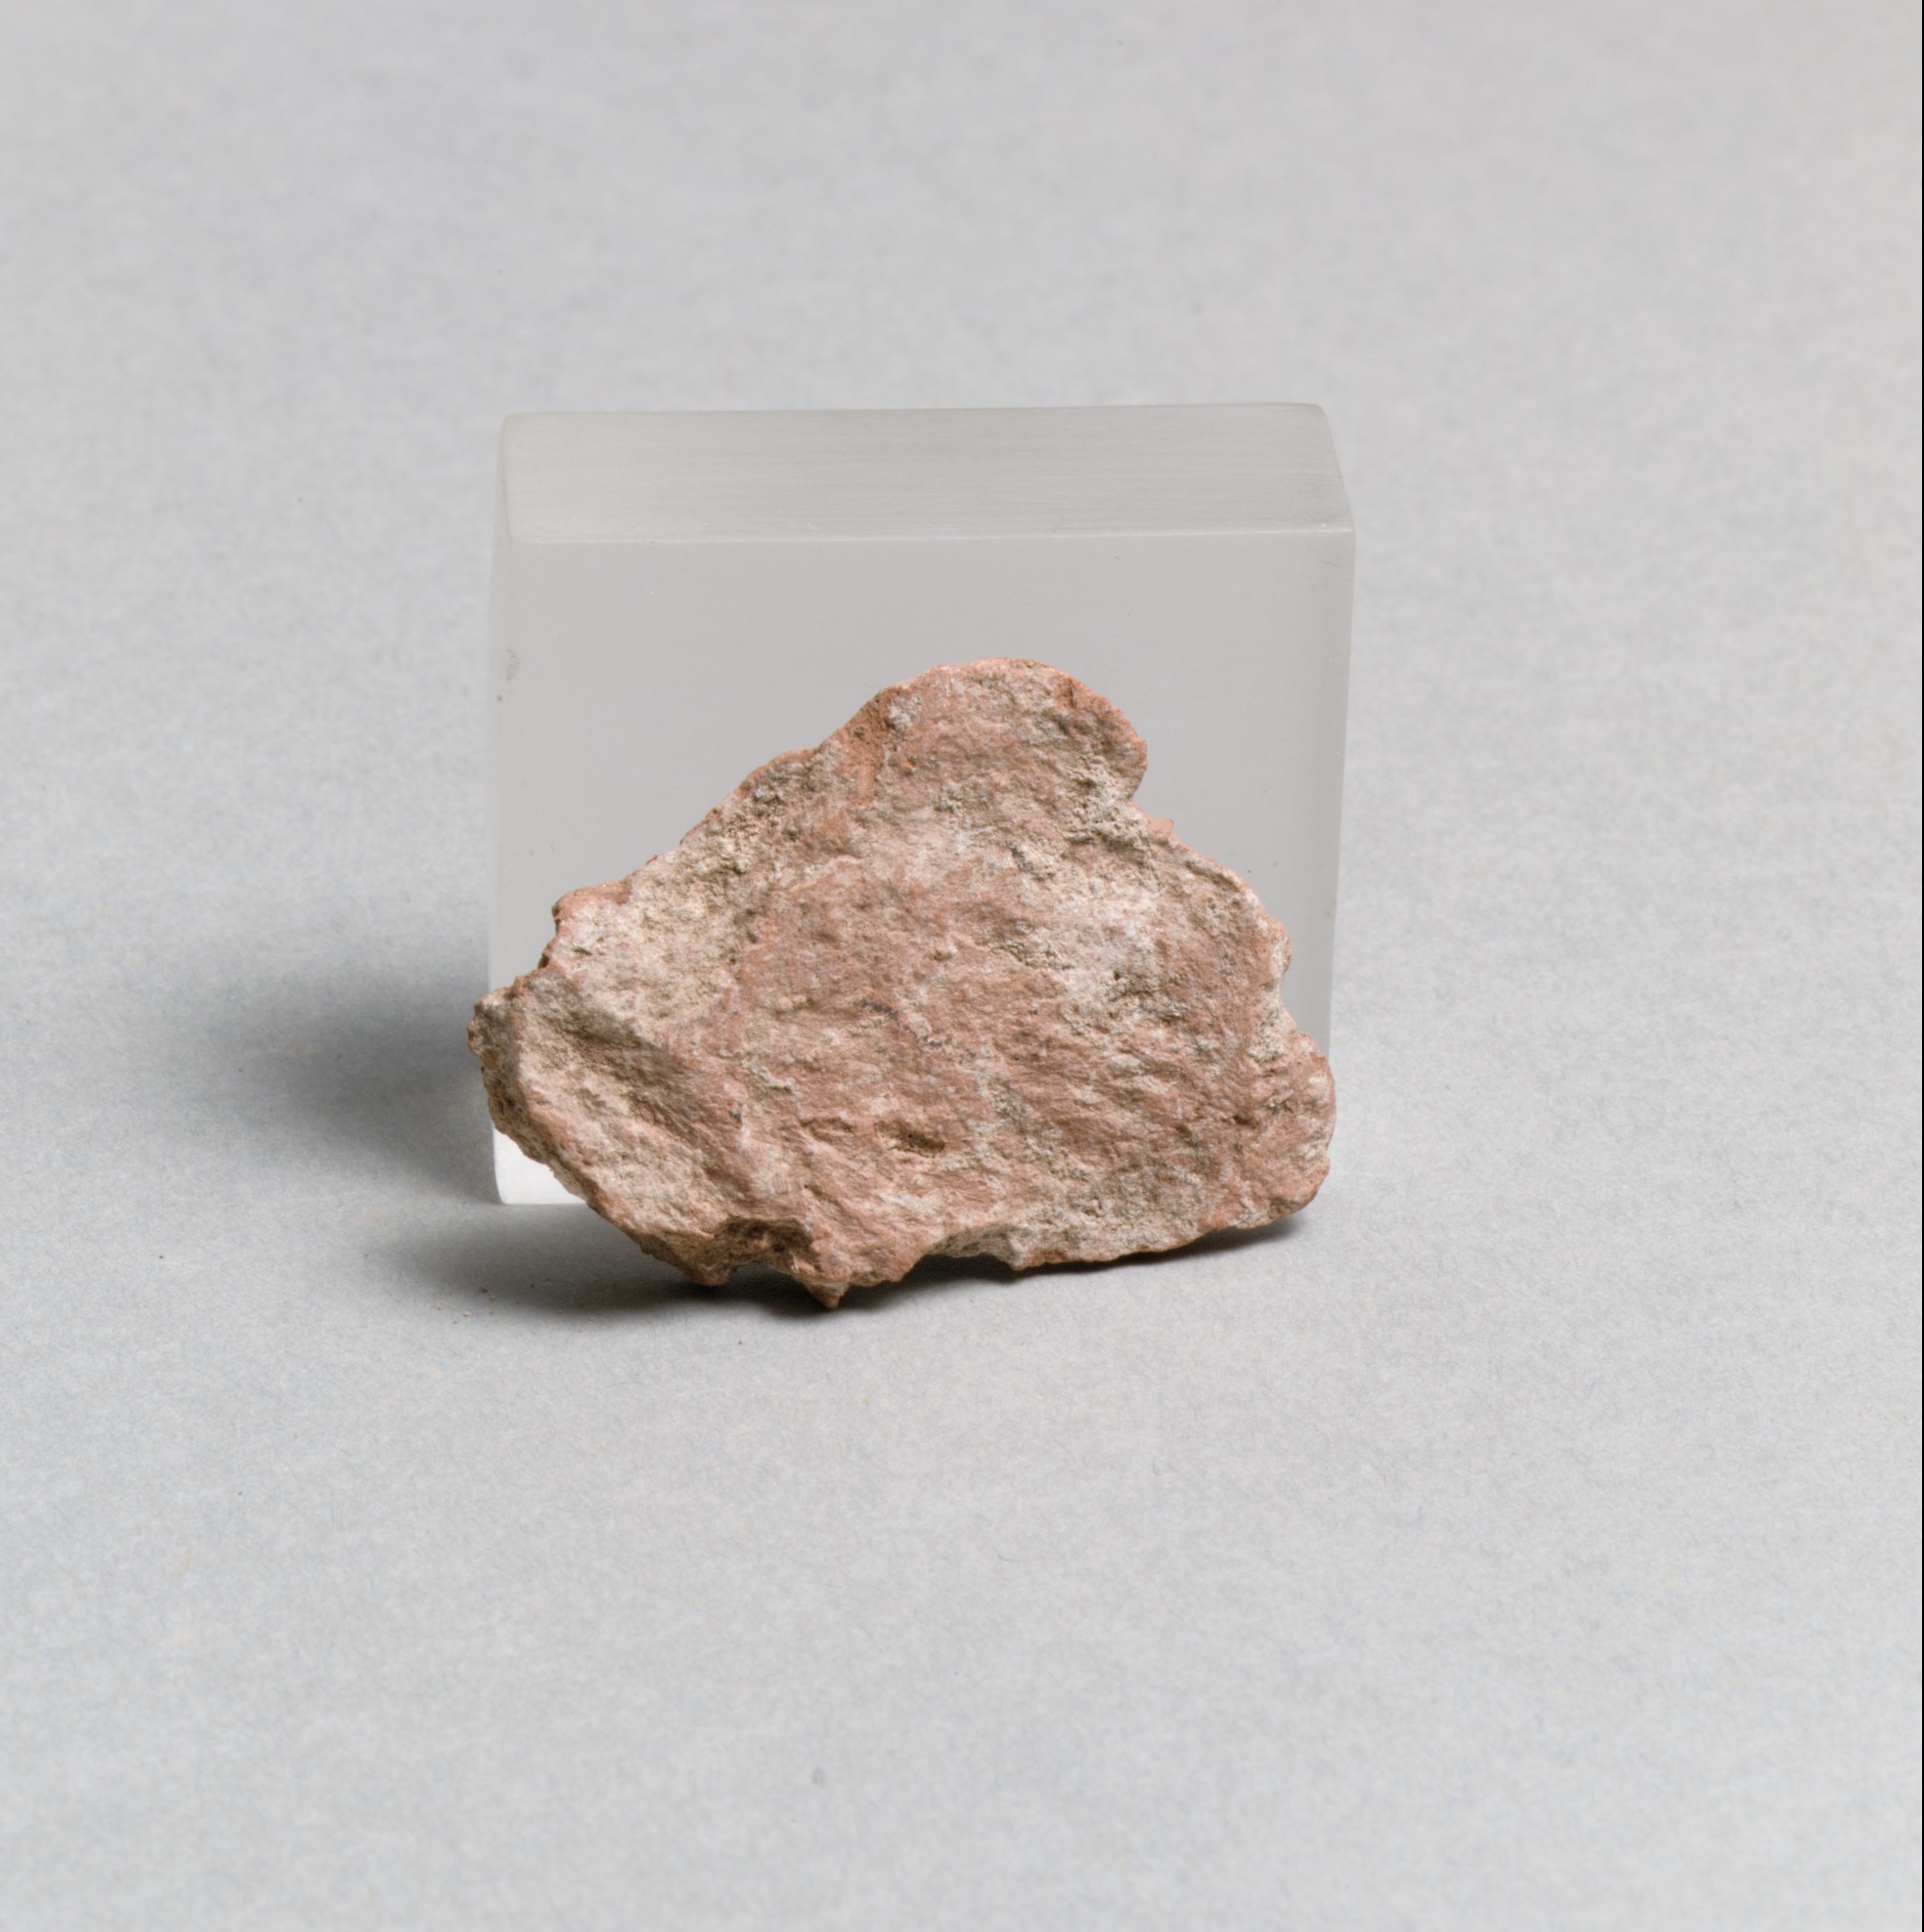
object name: vase fragment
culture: greek or lydian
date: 900-30 BCE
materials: terracotta